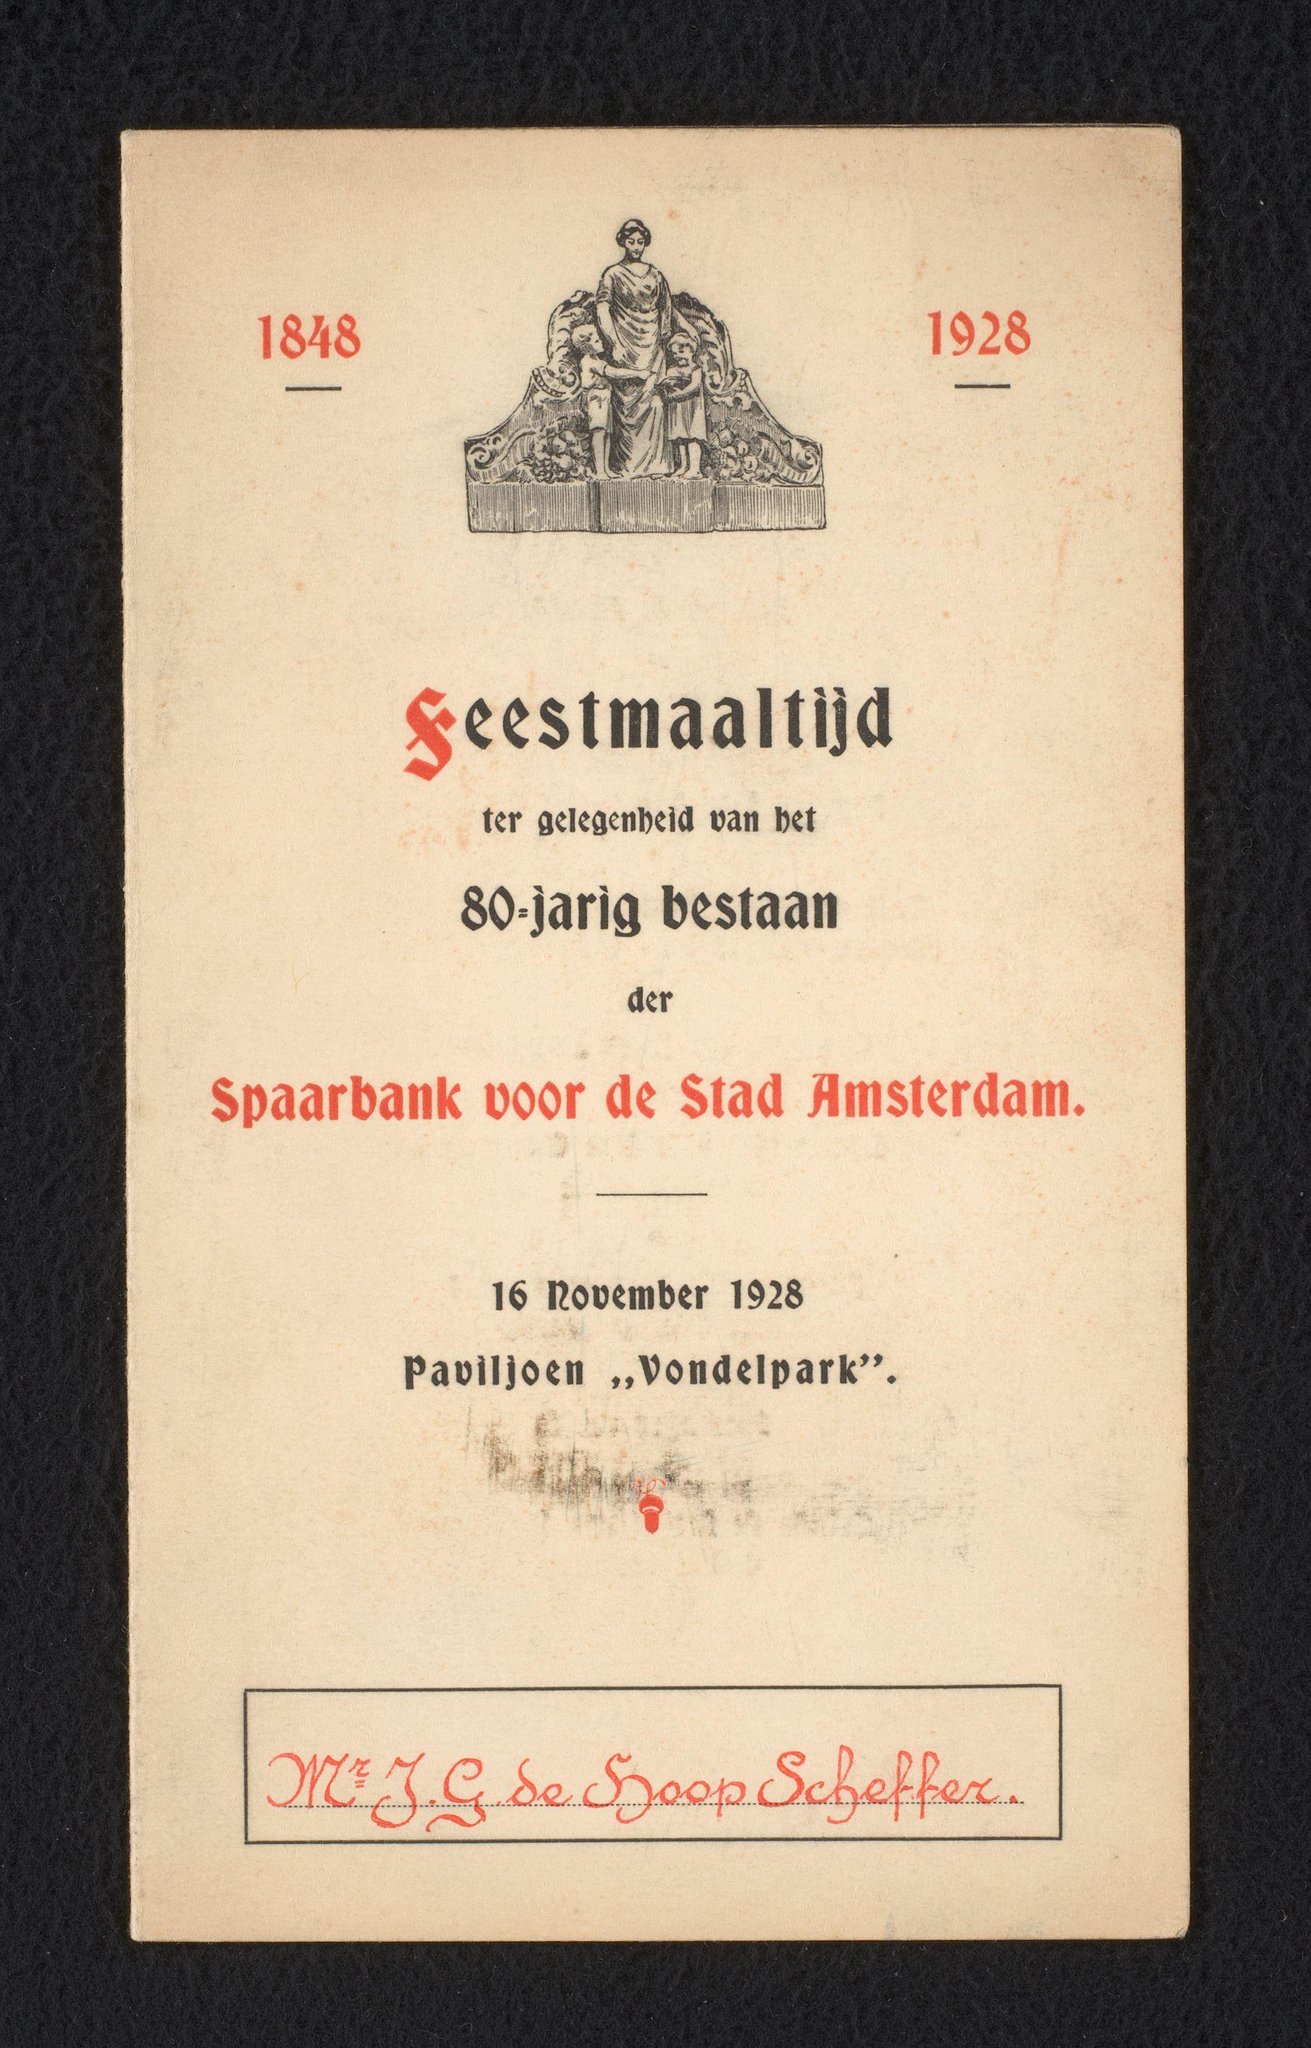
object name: photomechanical print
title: Menu voor de feestmaaltijd ter ere van het tachtigjarig bestaan van de Spaarbank voor de Stad Amsterdam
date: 1928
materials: paper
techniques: letterpress printing, printing block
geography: amsterdam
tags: sofa, night patrol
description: Op de voorzijde een beeld van een vrouw met aan weerszijden een kind. Daarbij de jaartallen 1848 en 1928. Onderaan de voorzijde is een kader met daarin ruimte voor de naam van de genodigde (in dit geval Mr. J.G. de Hoop Scheffer). Binnenin het menu en een opstelling van de directie en leden van de raad van toezicht van de Spaarbank voor de Stad Amsterdam als een schuttersstuk. Op de achterzijde een legenda voor de afgebeelde personen. Diner op 16 november 1928 in paviljoen 'Vondelpark' in Amsterdam.